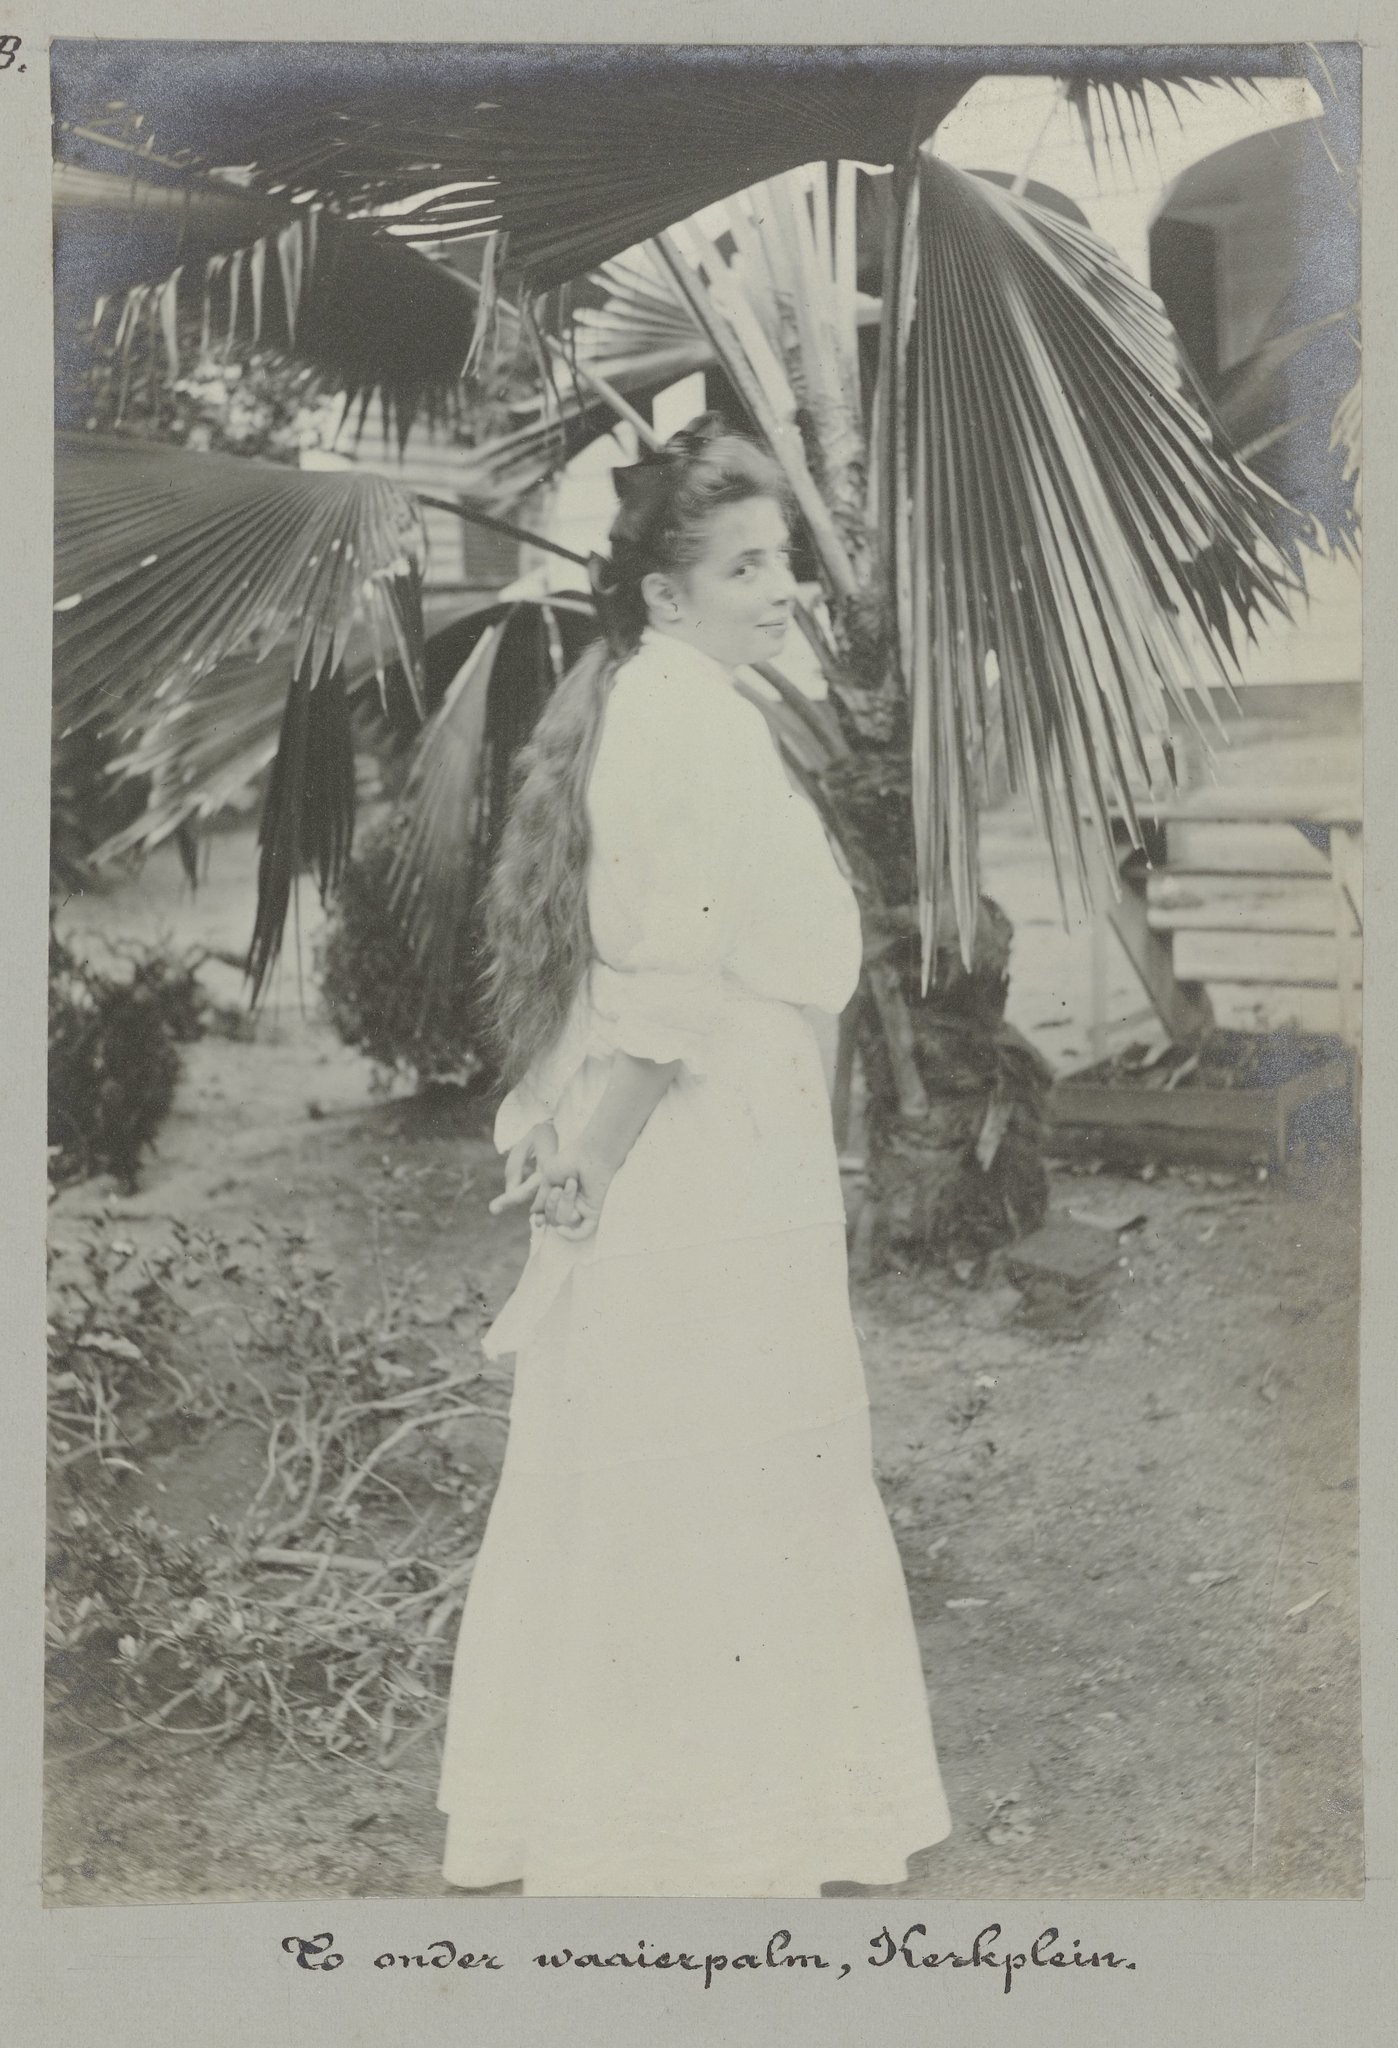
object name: photograph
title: To onder waaierpalm, Kerkplein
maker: gomez burke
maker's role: fotograaf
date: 1891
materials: photographic support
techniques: gelatin silver print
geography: suriname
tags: suriname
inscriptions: inscription: ‘G.B. / To onder waaierpalm, Kerkplein.’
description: Portret van de jonge Nederlandse vrouw genaamd To, staande onder een waaierpalm in de tuin van het huis aan het Kerkplein te Paramaribo. Onderdeel van het fotoalbum Souvenir de Voyage (deel 4), over het leven van de familie Dooyer in en rond de plantage Ma Retraite in Suriname in de jaren 1906-1913.